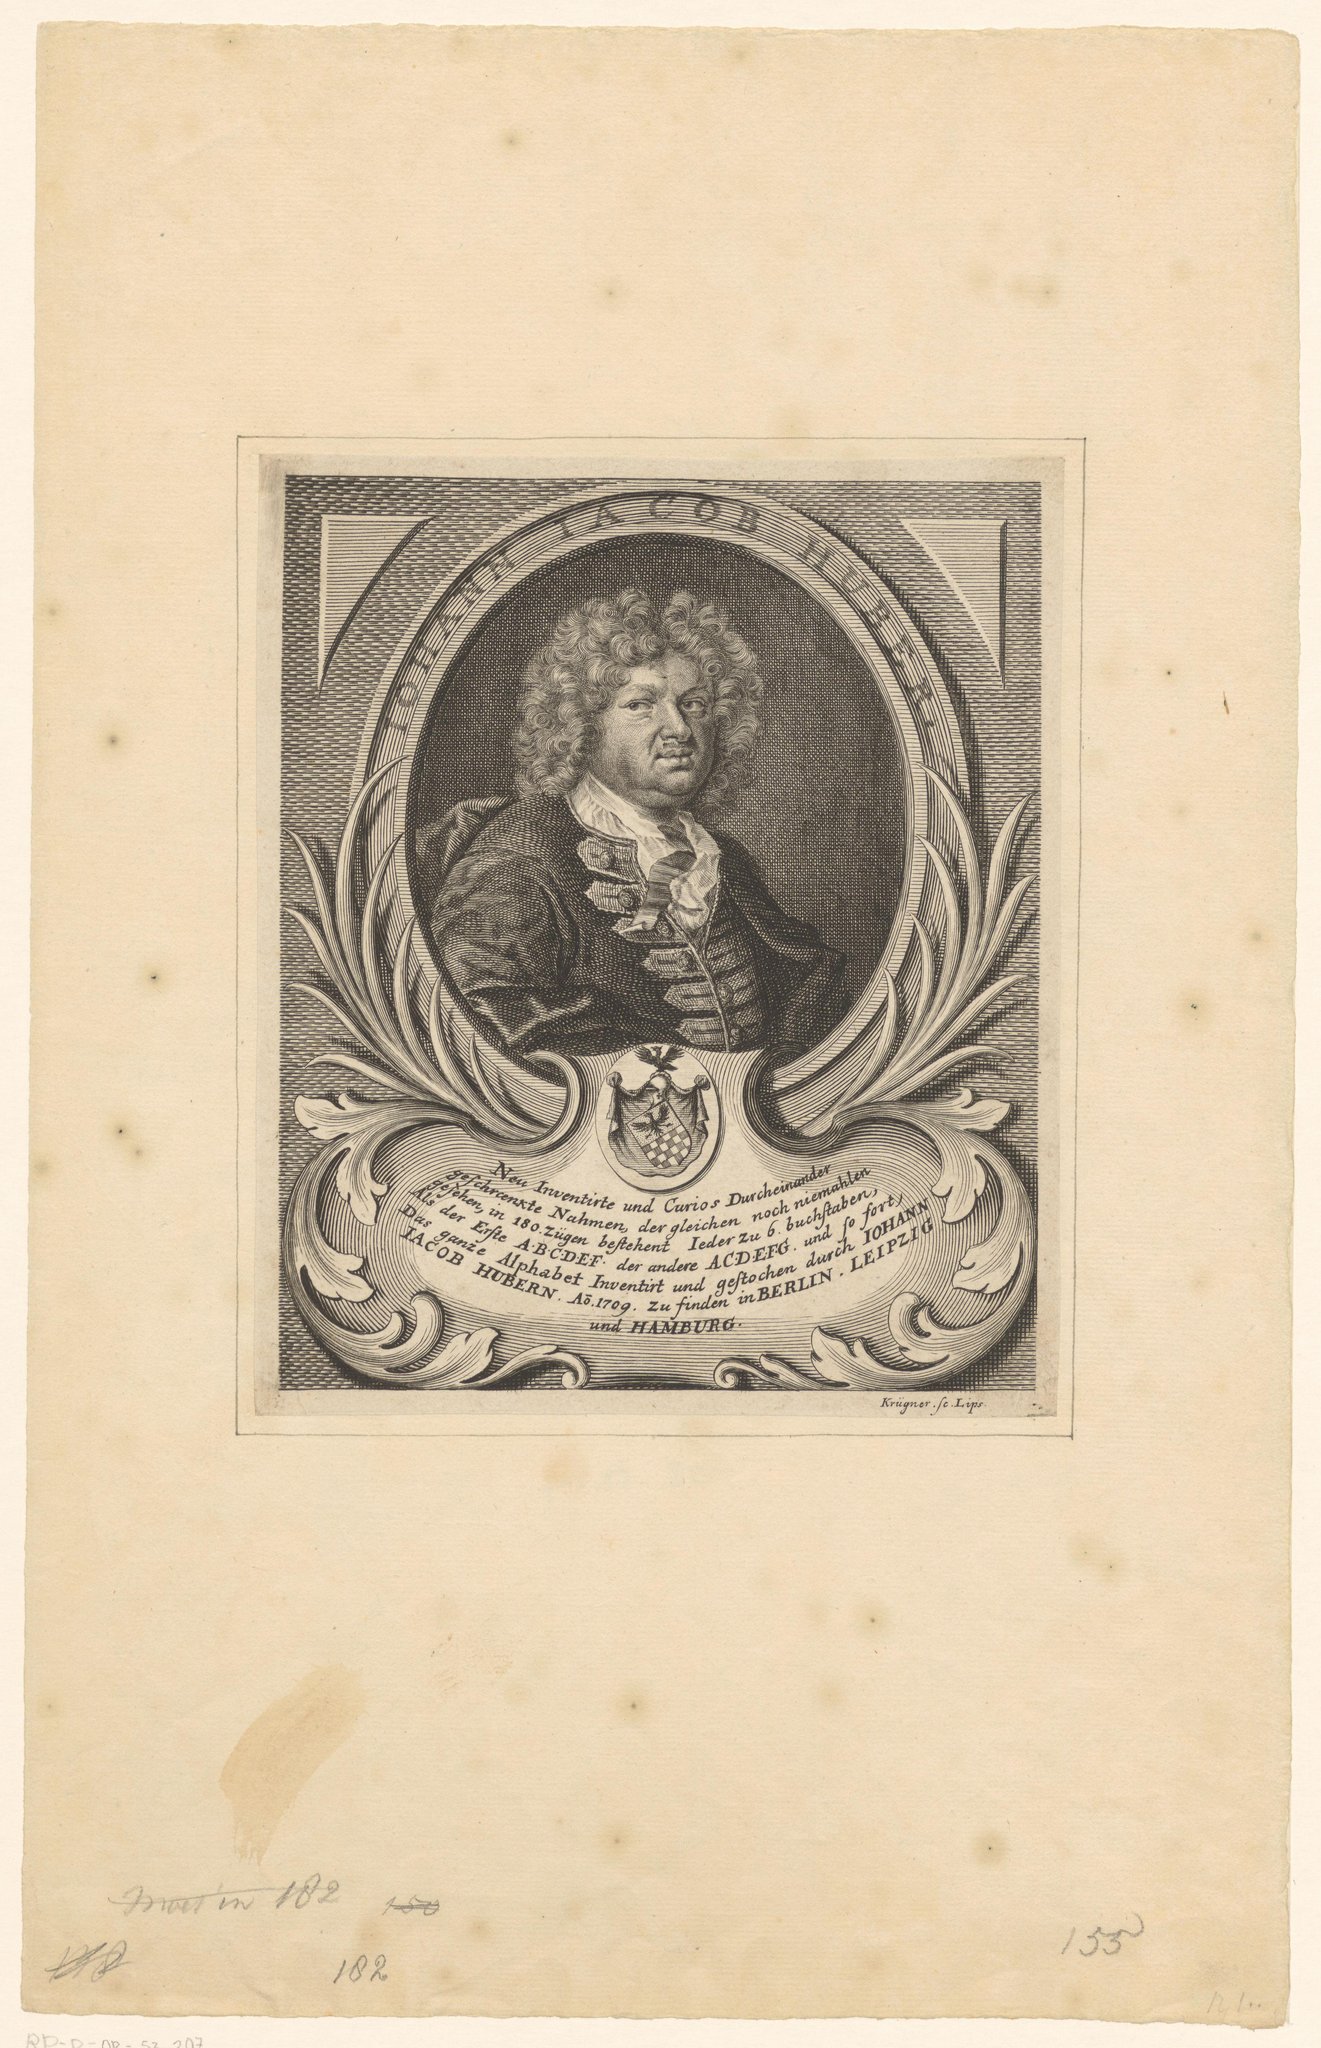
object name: print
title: Portret van Johann Jacob Huber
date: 1709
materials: paper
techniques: engraving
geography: leipzig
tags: artist, historical persons, portrait, self-portrait of graphic artist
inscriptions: collector's mark: Lugt 2228